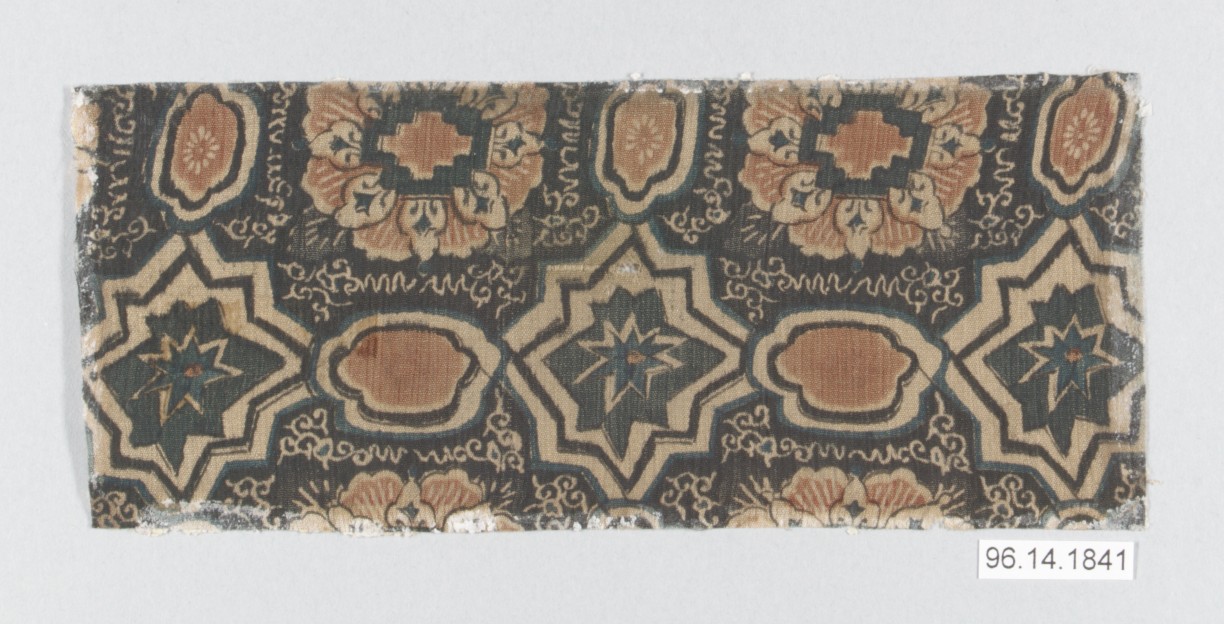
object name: piece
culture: japanese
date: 1701-1900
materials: silk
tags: leaves